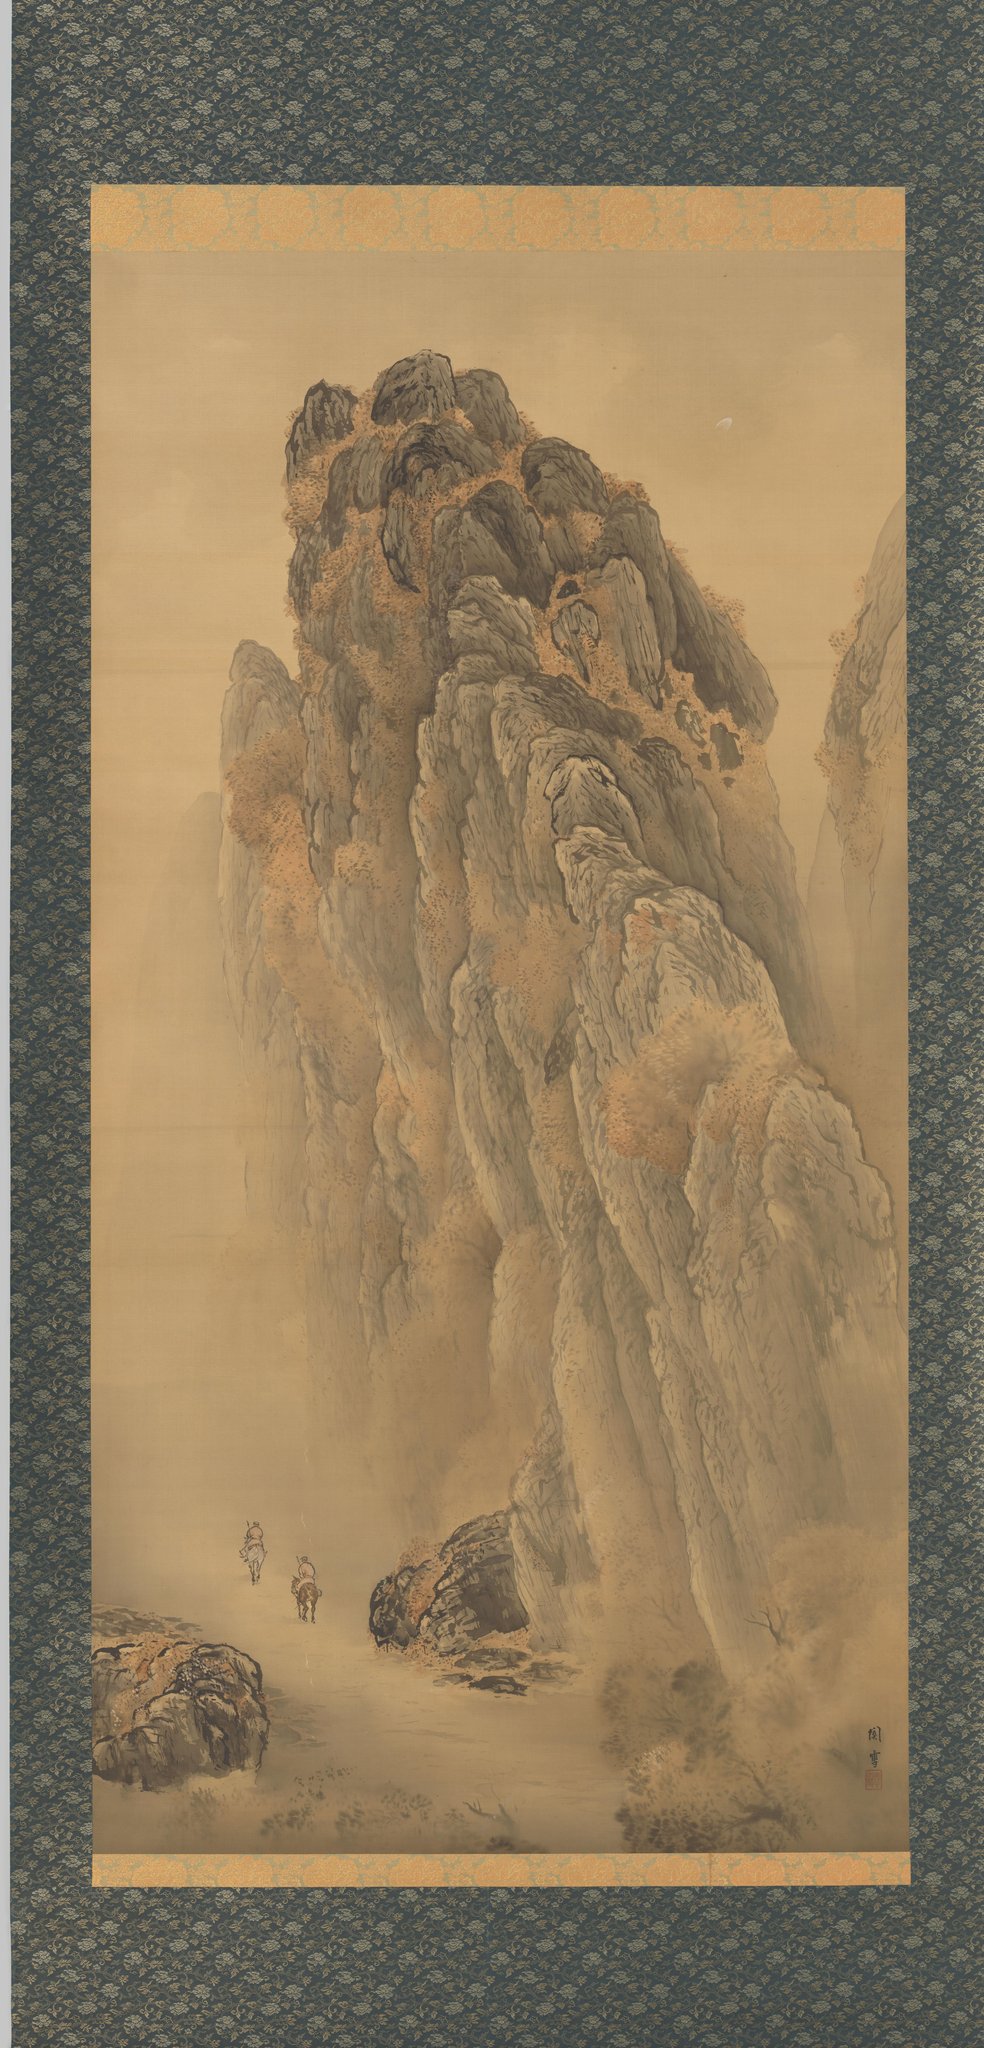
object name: hanging scroll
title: Landscape in China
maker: hashimoto kansetsu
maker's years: 1883-1945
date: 1930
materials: ink, paint, pigment, silk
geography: tokyo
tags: china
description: Kansetsu had a deep and abiding interest in China and visited the country numerous times. This landscape was inspired by works from the 11th century. The tiny horsemen give a sense of man’s insignificance in the face of overwhelming nature. Kansetsu paid great attention to the texture of the rocks and trees, rendering them with lively brushstrokes.